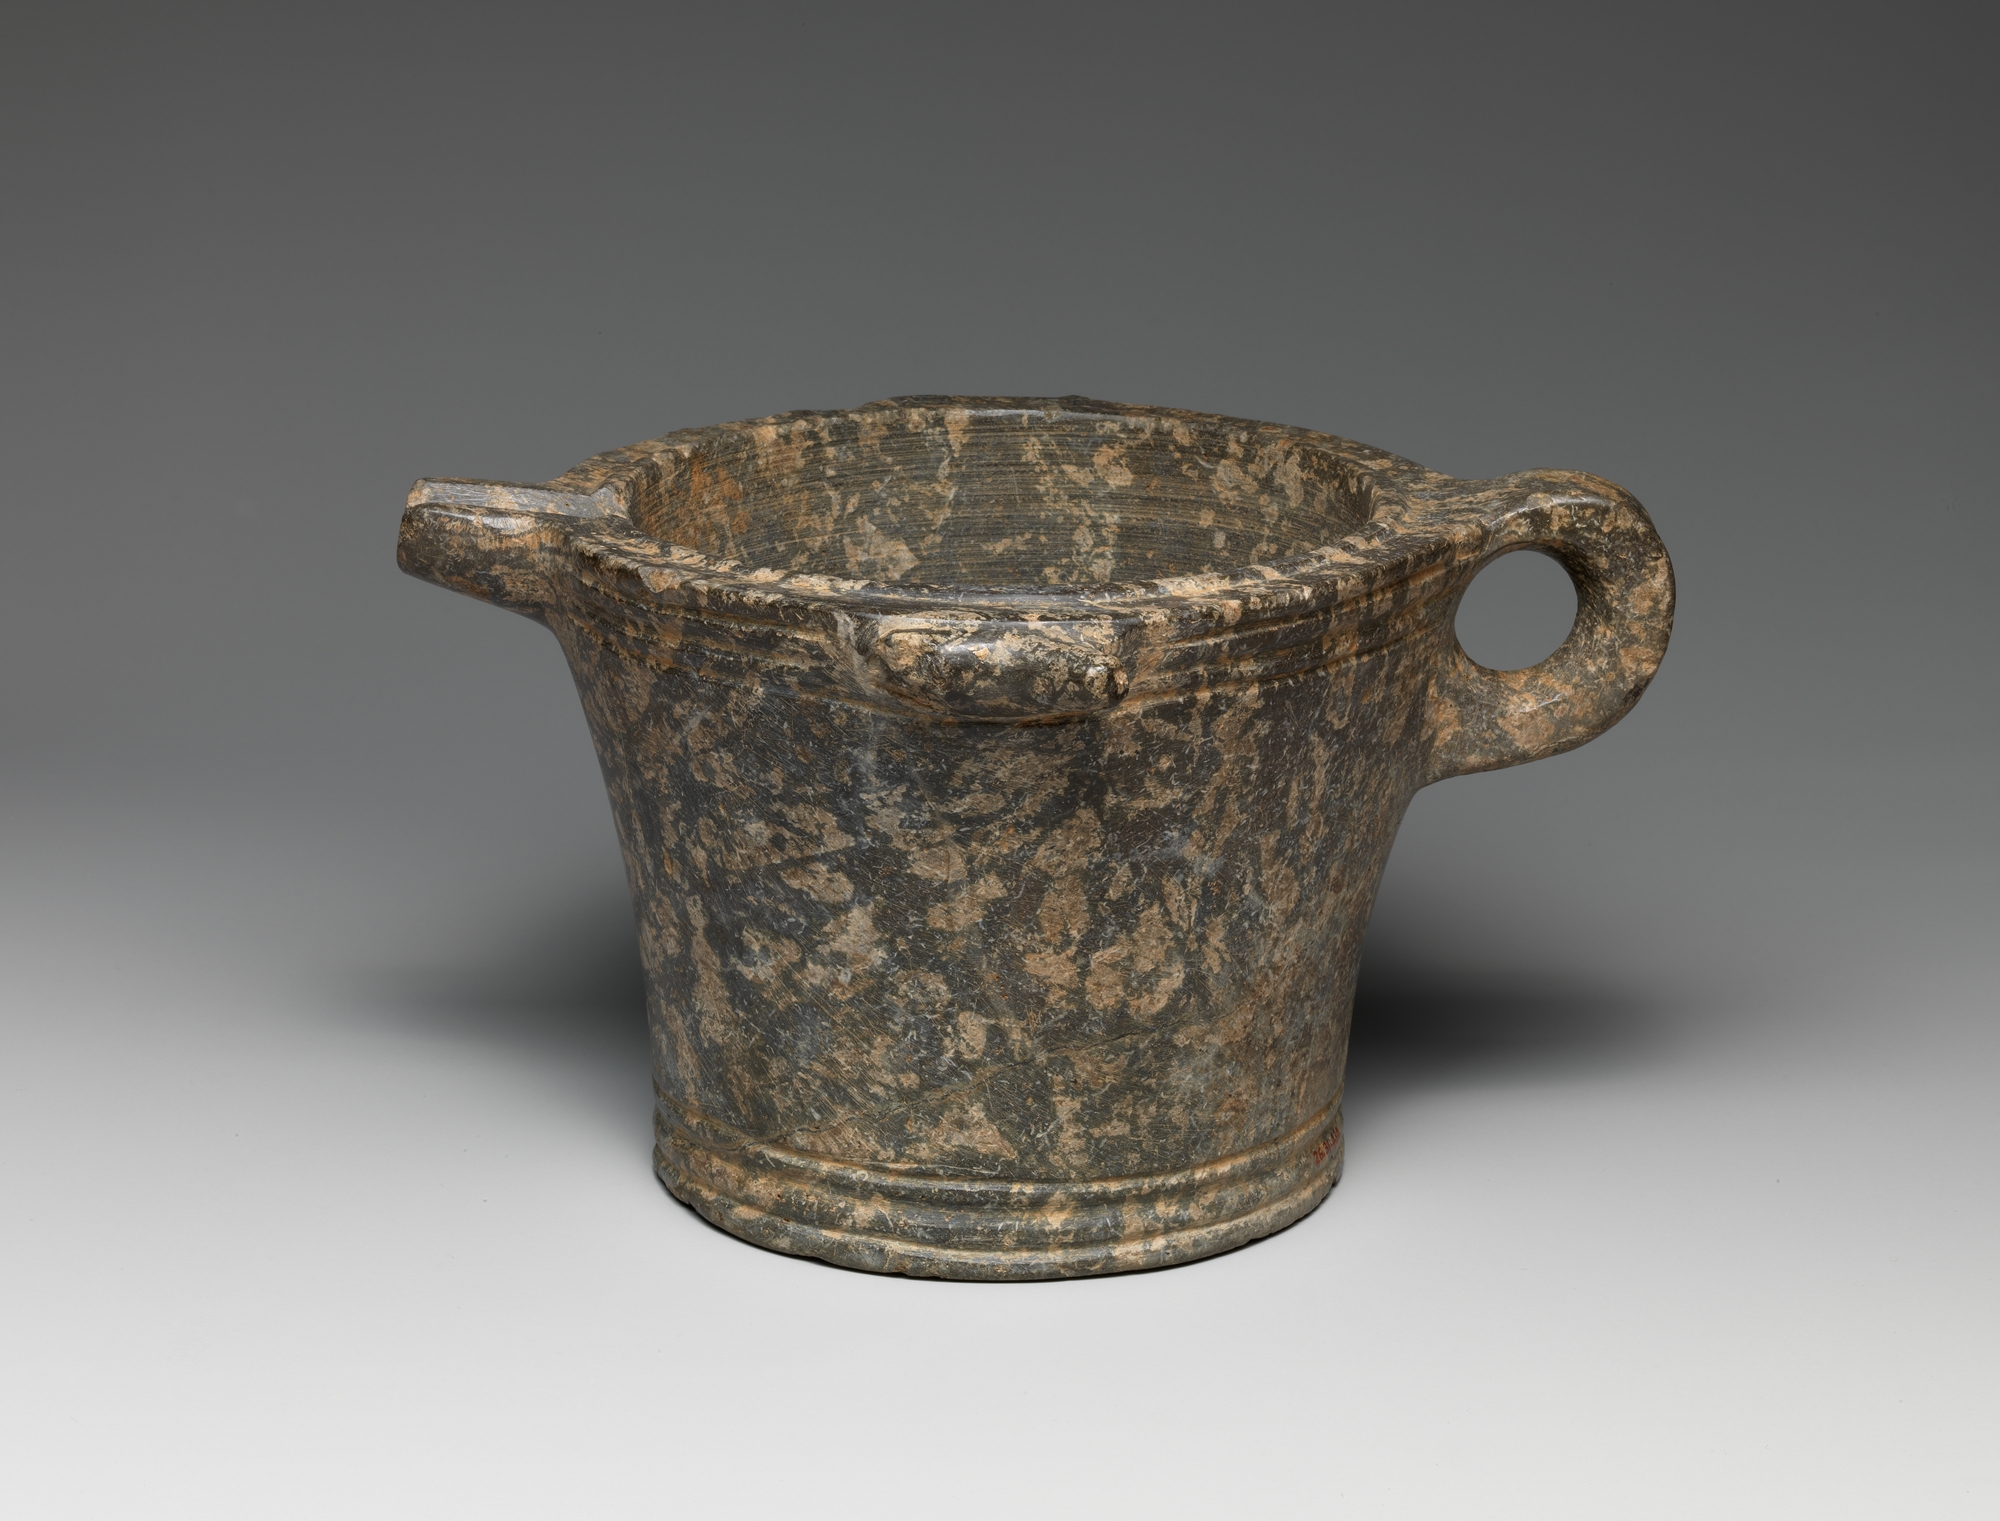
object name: bowl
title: Serpentine bowl with spout and handle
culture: minoan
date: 1600-1450 BCE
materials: stone